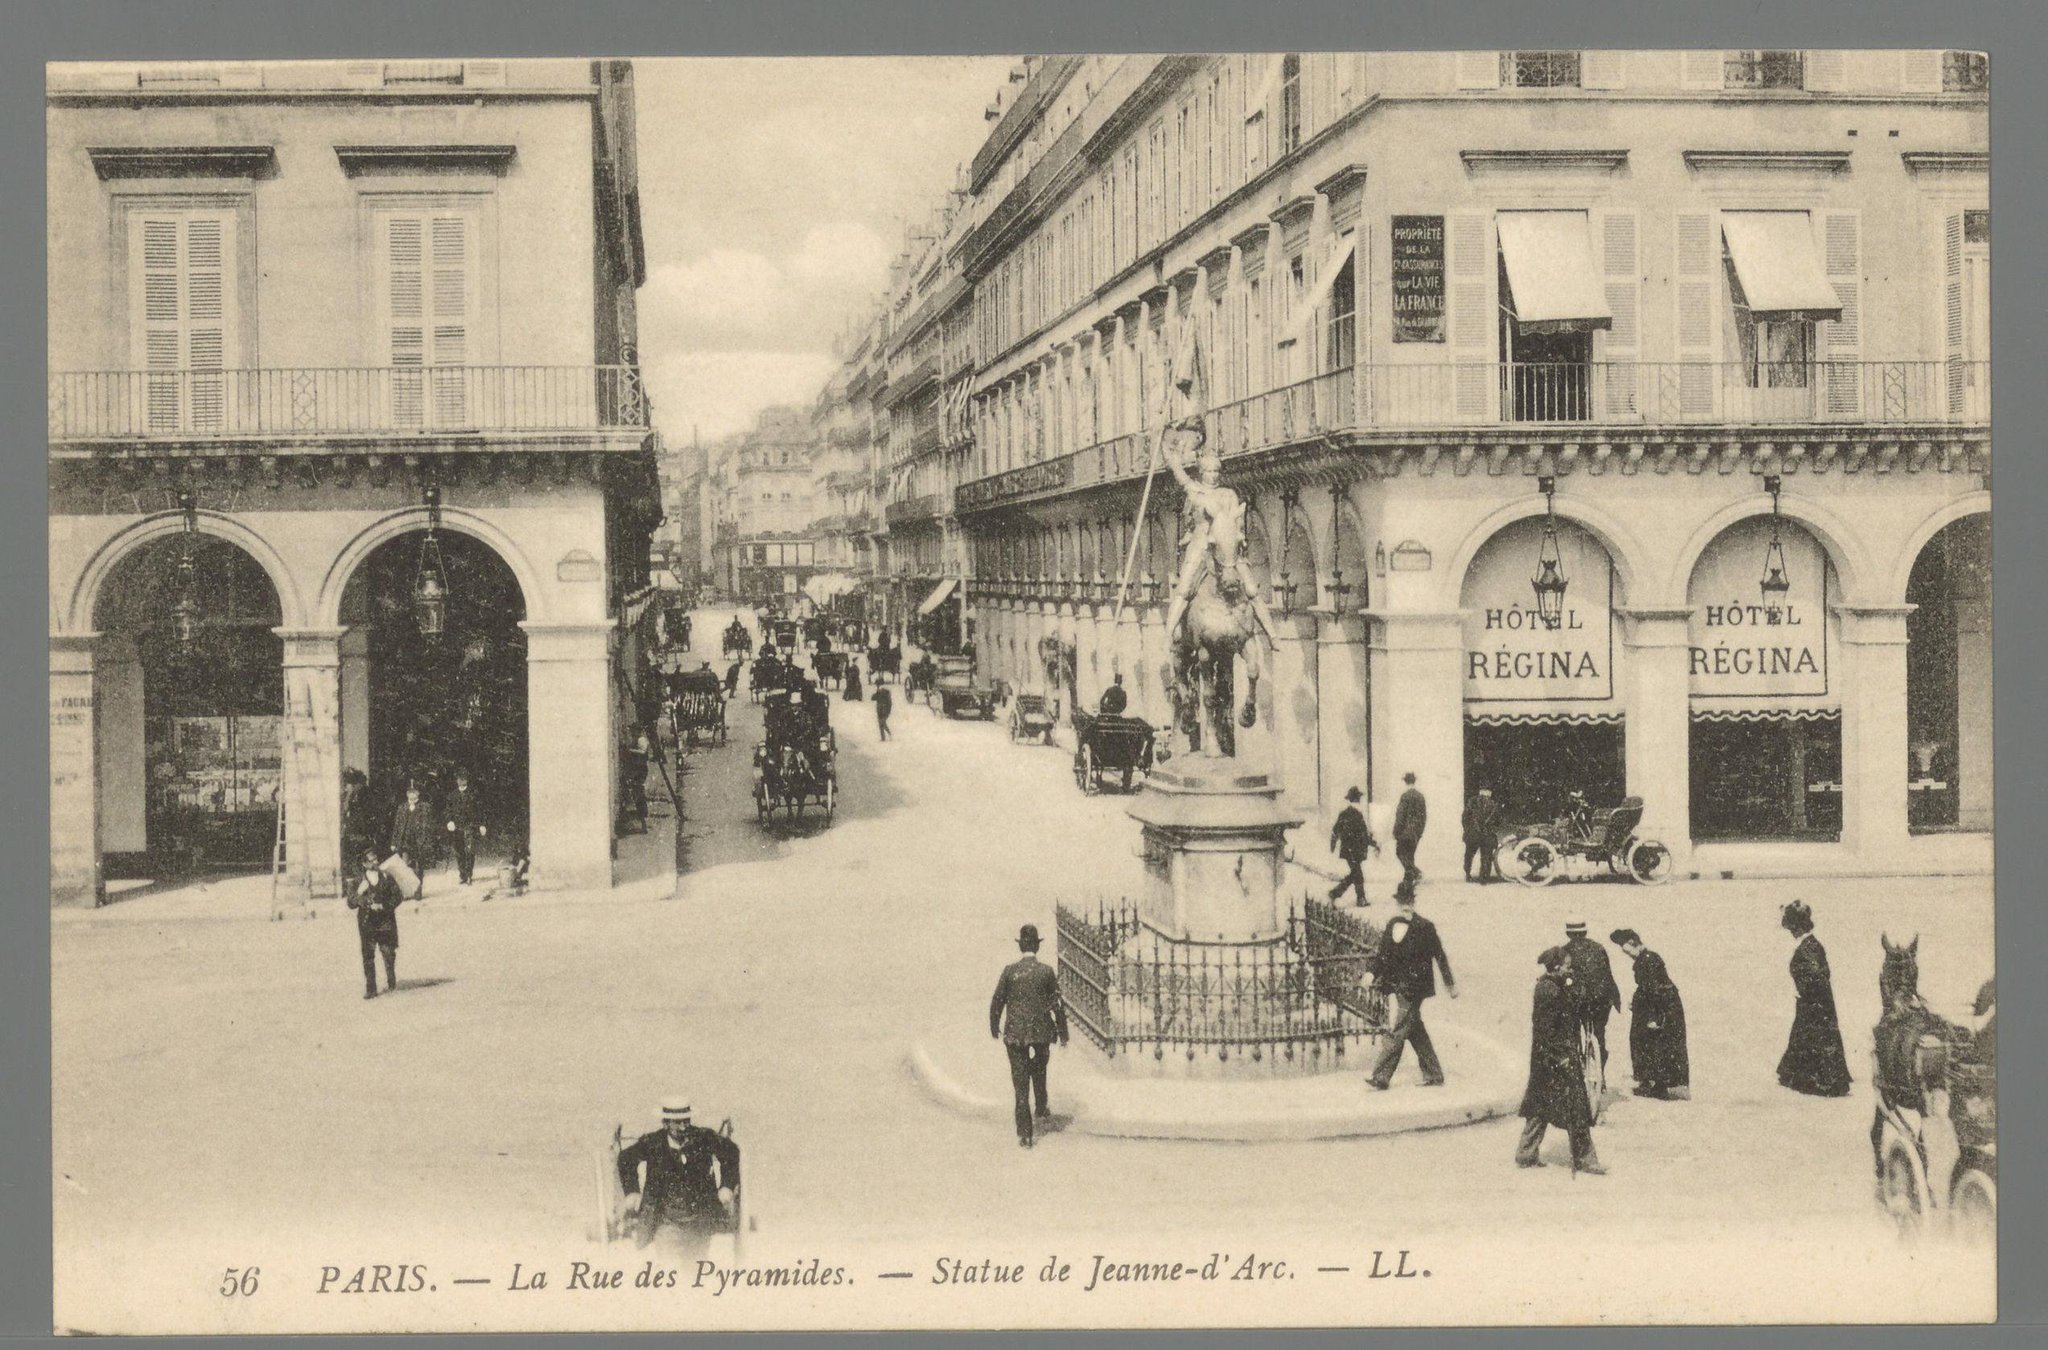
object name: photomechanical print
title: Paris. La Rue des Pyramides. Statue de Jeanne d'Arc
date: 1904-1906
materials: cardboard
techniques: photograph, writing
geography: paris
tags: monument, statue, square, place, circus, etc. (+ city(-scape) with figures, staffage), paris